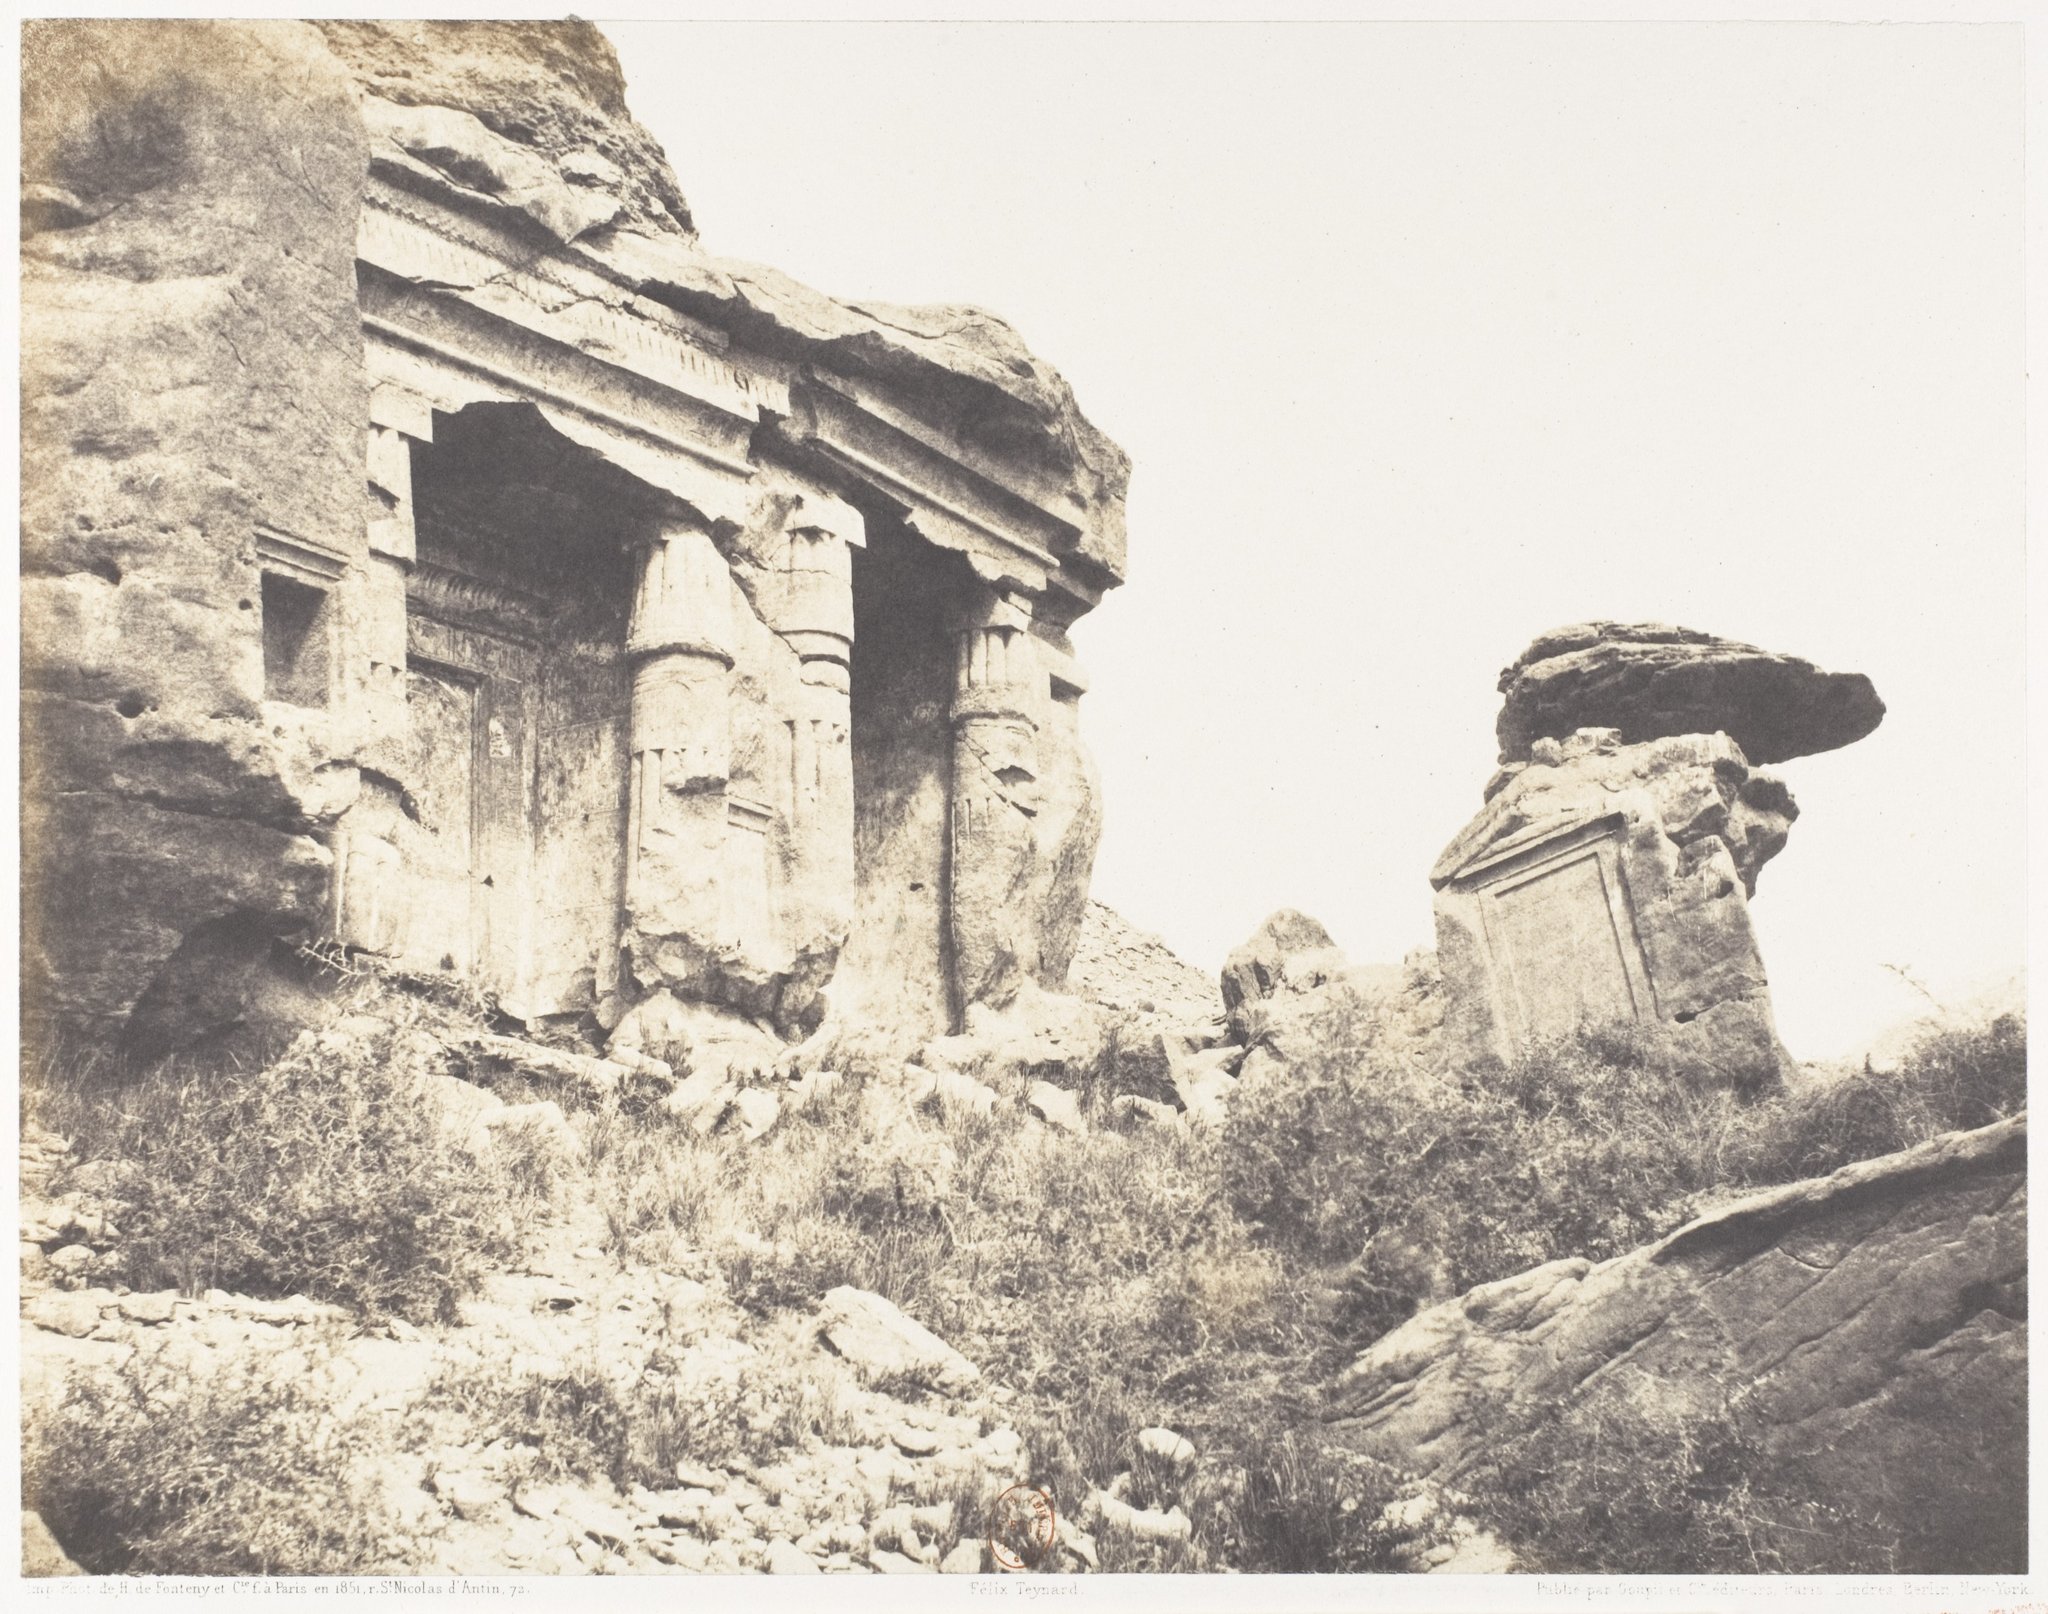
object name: photograph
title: Djébel Selséleh (Silsilis), Steles Architecturales Taillées Dans les Carriéres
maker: félix teynard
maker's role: artist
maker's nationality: french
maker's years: 1817-1892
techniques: paper negative, salted paper print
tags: architecture,ruins